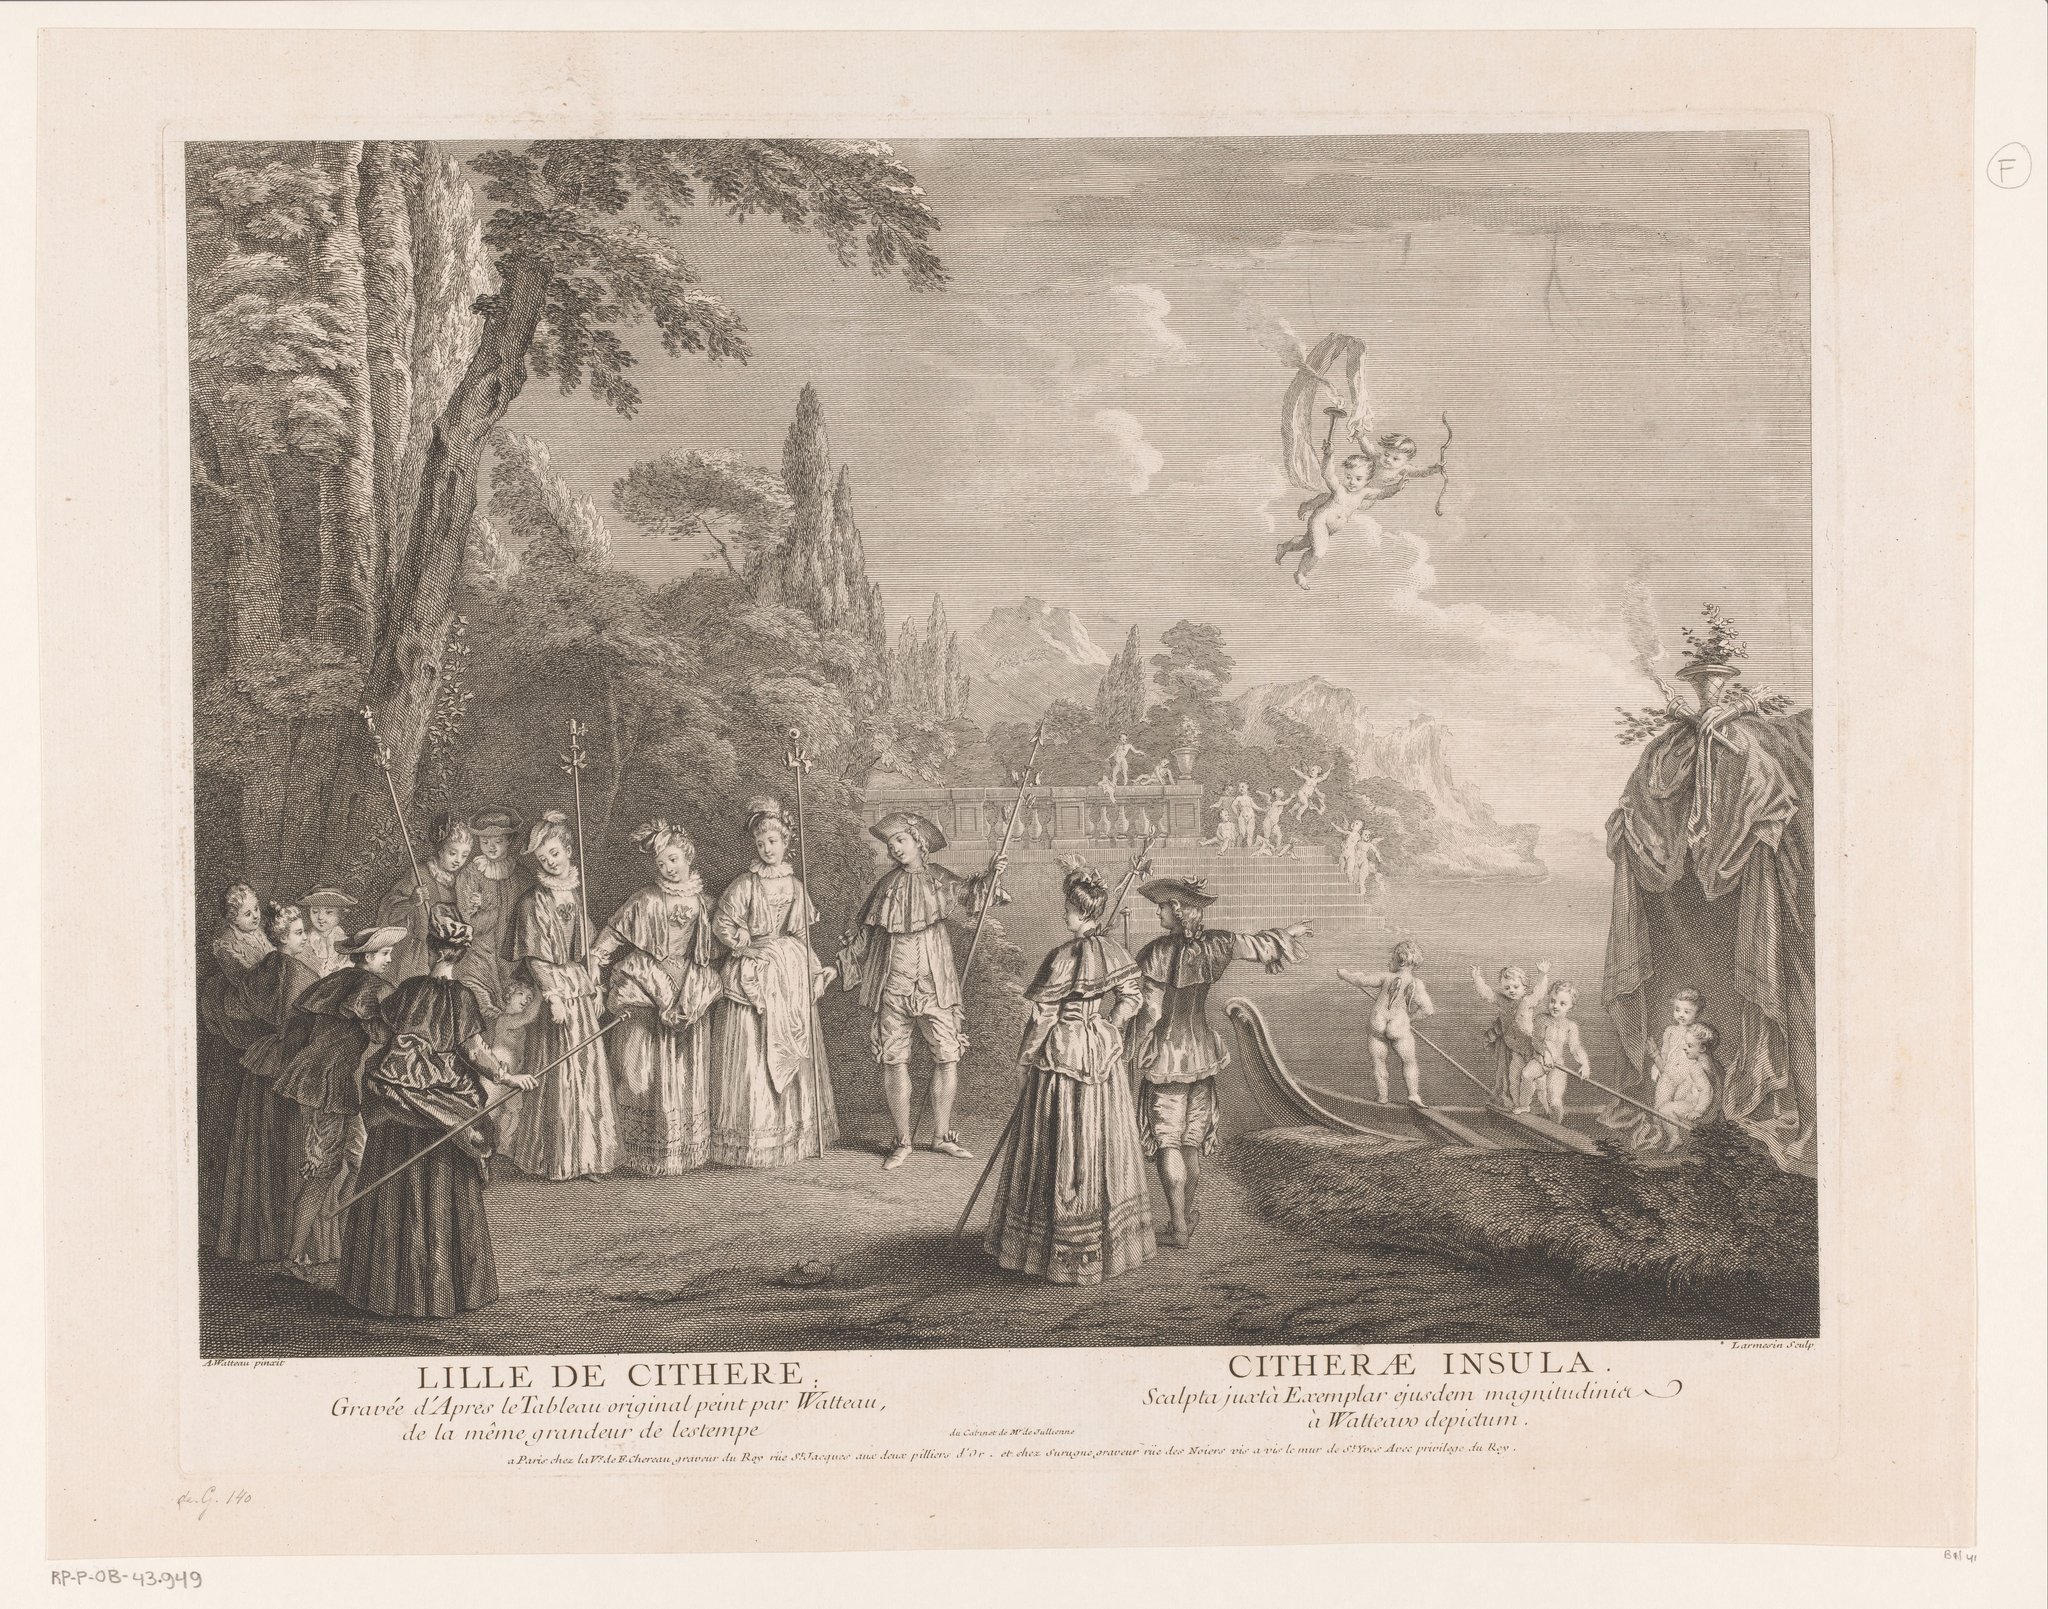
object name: print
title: Gezicht op het eiland Cythera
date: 1735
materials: paper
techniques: engraving, etching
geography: france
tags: 'ile de cythère'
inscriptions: collector's mark: Lugt 2228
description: Maakt deel uit van een serie van 271 platen, inclusief twee titelprenten, naar schilderijen door Watteau en verzameld door Jean de Jullienne. Sommige platen werden reeds tijdens Watteau's leven vervaardigd en de rest kwam pas na zijn dood tot stand. In 1734 werd het eind van de serie aangekondigd.